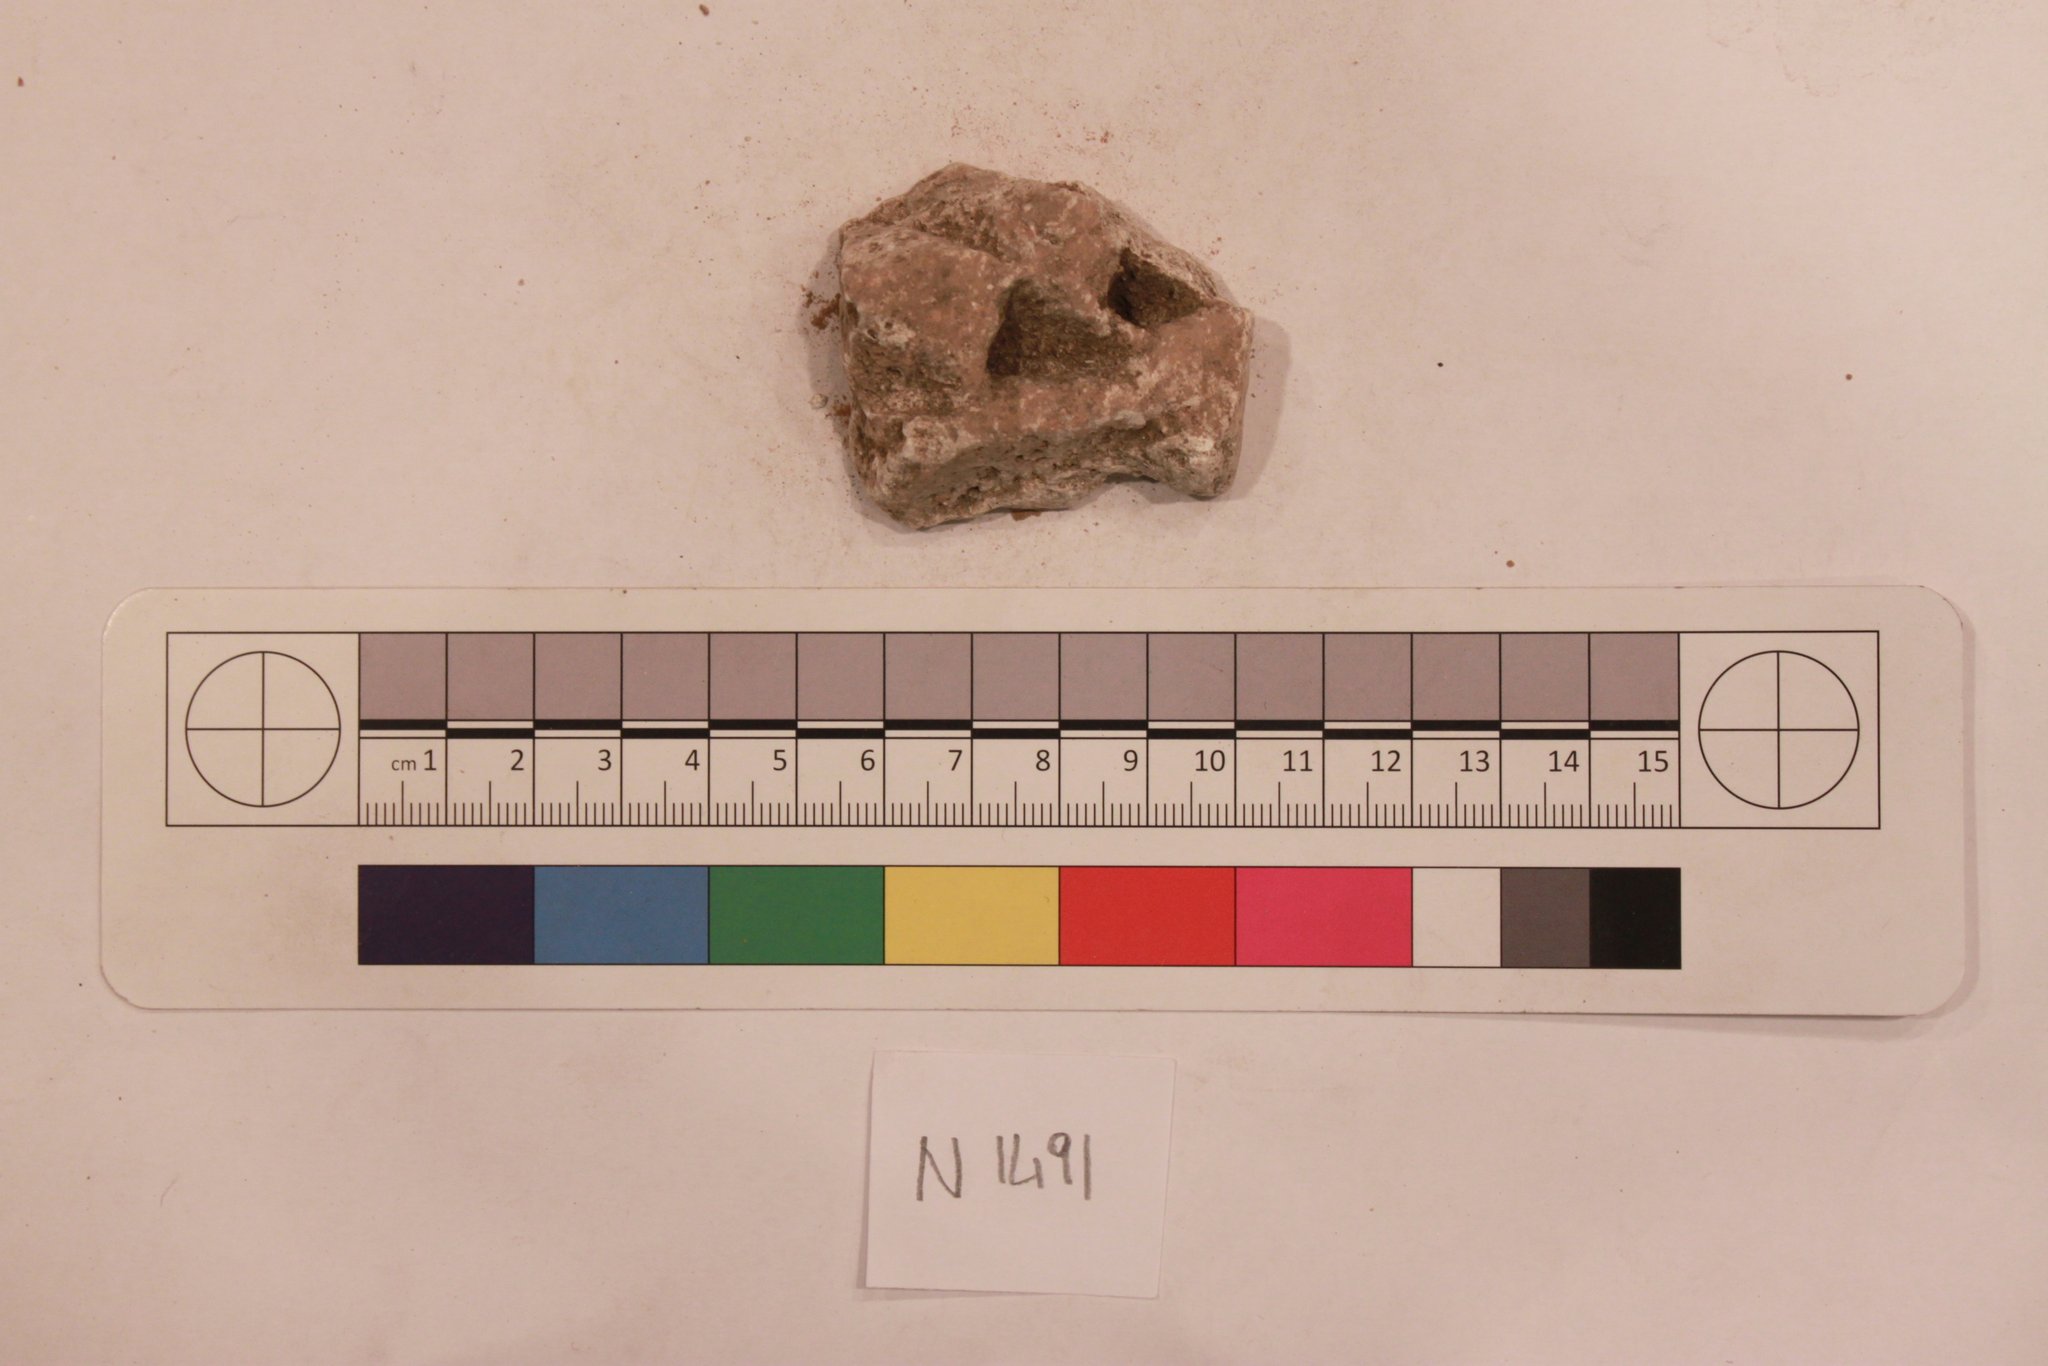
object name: fragment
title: Stucco Fragment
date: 701-1200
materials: plaster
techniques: carving, painting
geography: iran